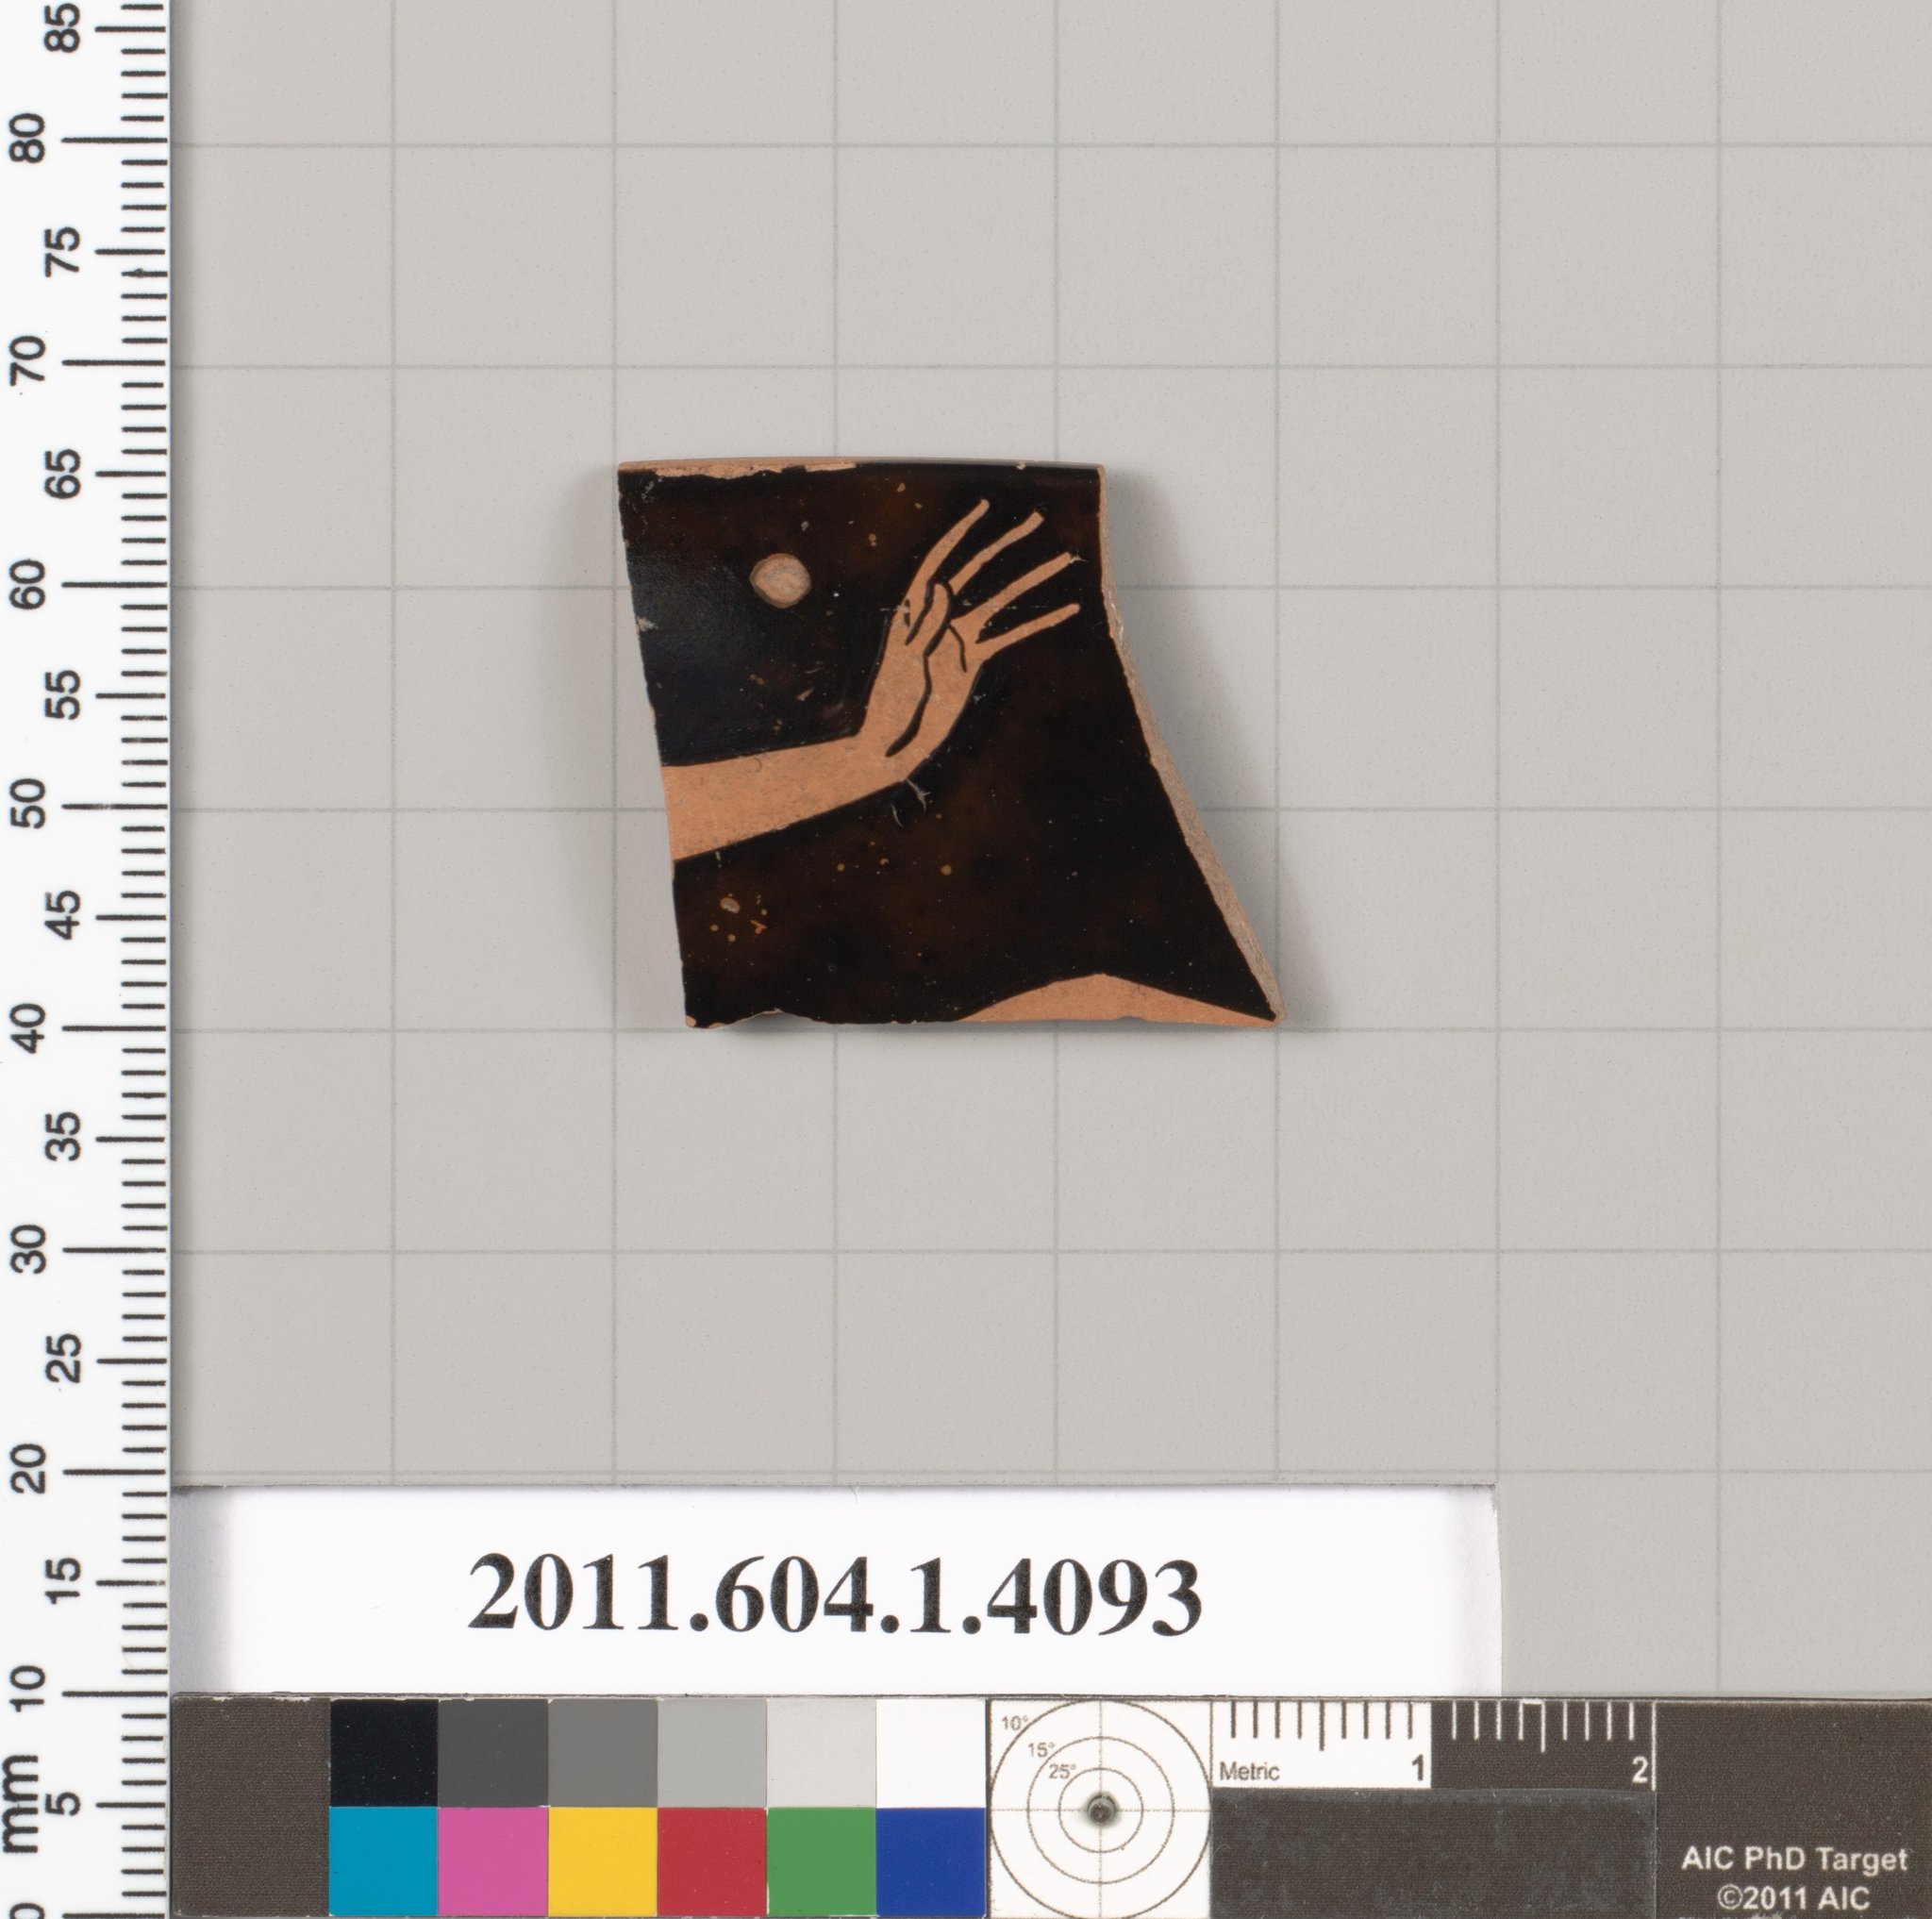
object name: kylix fragment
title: Terracotta rim fragment of a kylix (drinking cup)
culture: greek, attic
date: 520-500 BCE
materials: terracotta